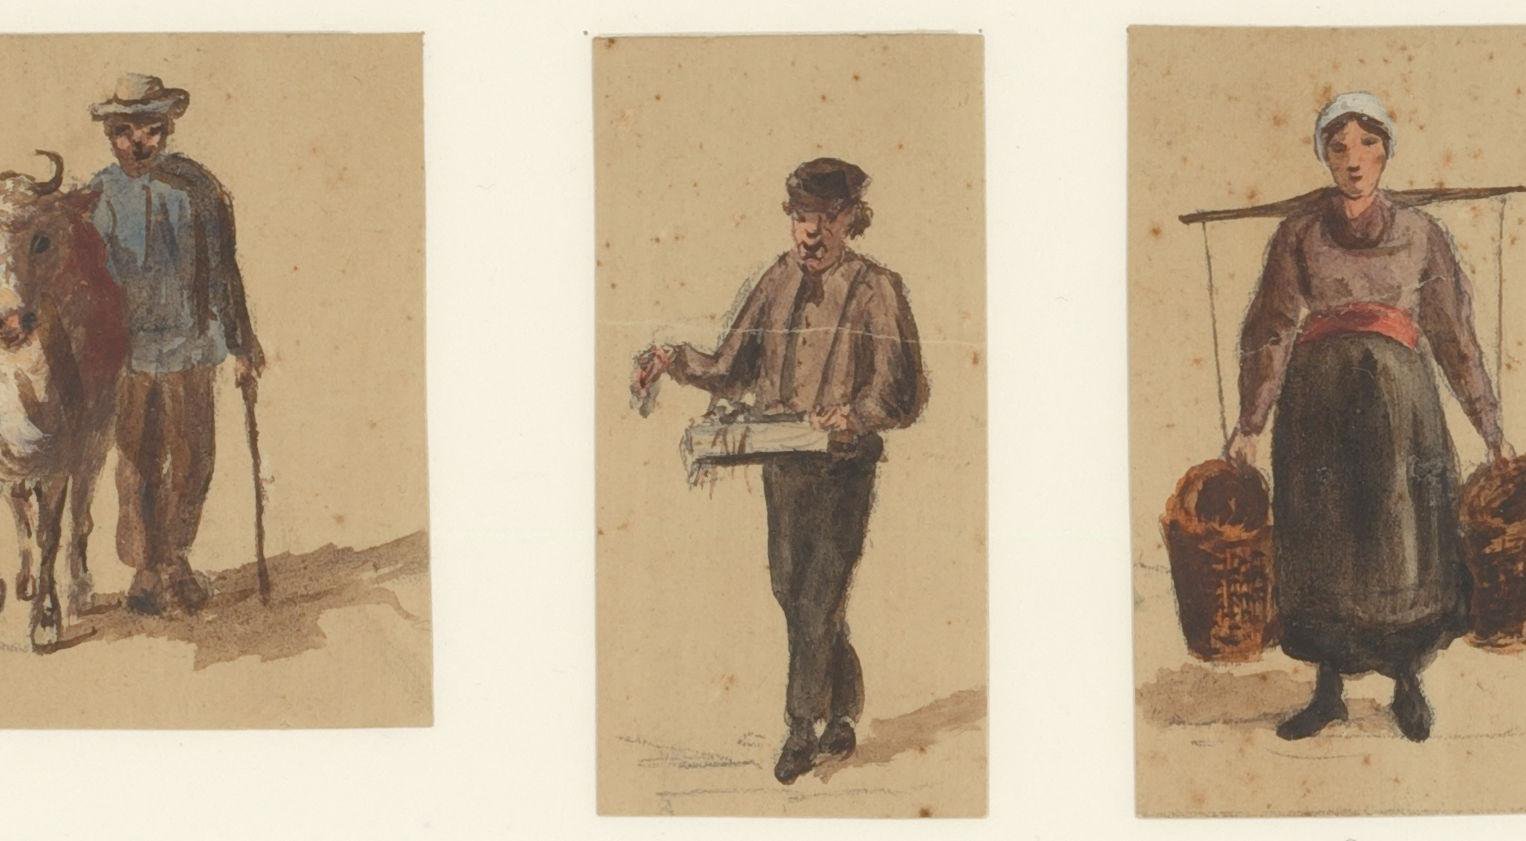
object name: drawing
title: Straatverkoper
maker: pierre jean fardon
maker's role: amateurschilder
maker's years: 1838-1911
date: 1850-1911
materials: chalk, paper, watercolor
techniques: brush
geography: netherlands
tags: street-trader, amsterdam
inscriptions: collector's mark: Lugt 1641, collector's mark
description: Een venter verkoopt koopwaar vanuit een bak aan een riem om zijn nek. Onderdeel van een serie van 16 bladen met tekeningen van Amsterdamse volkstypen. Onderwerpsrubrieken binnen de Atlas Zeden en Gewoonten: Mannelijk beroep en bedrijf: Marskramers, straatventers, straatslijpers, bedelaars, straatvertooningen enz.